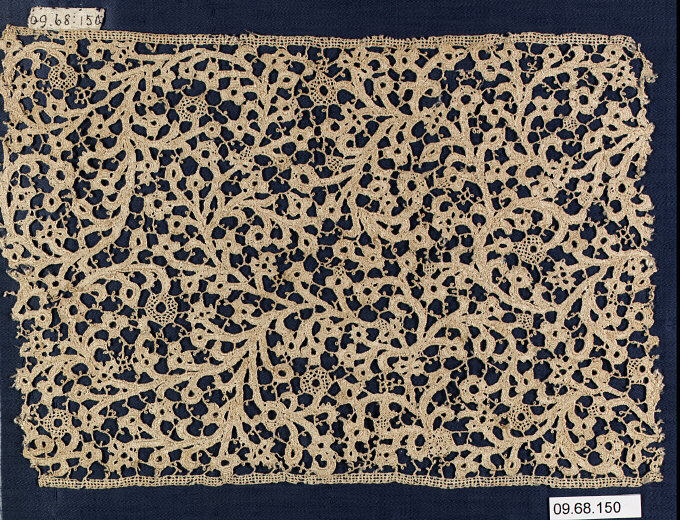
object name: fragment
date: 1601-1700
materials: silk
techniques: lace